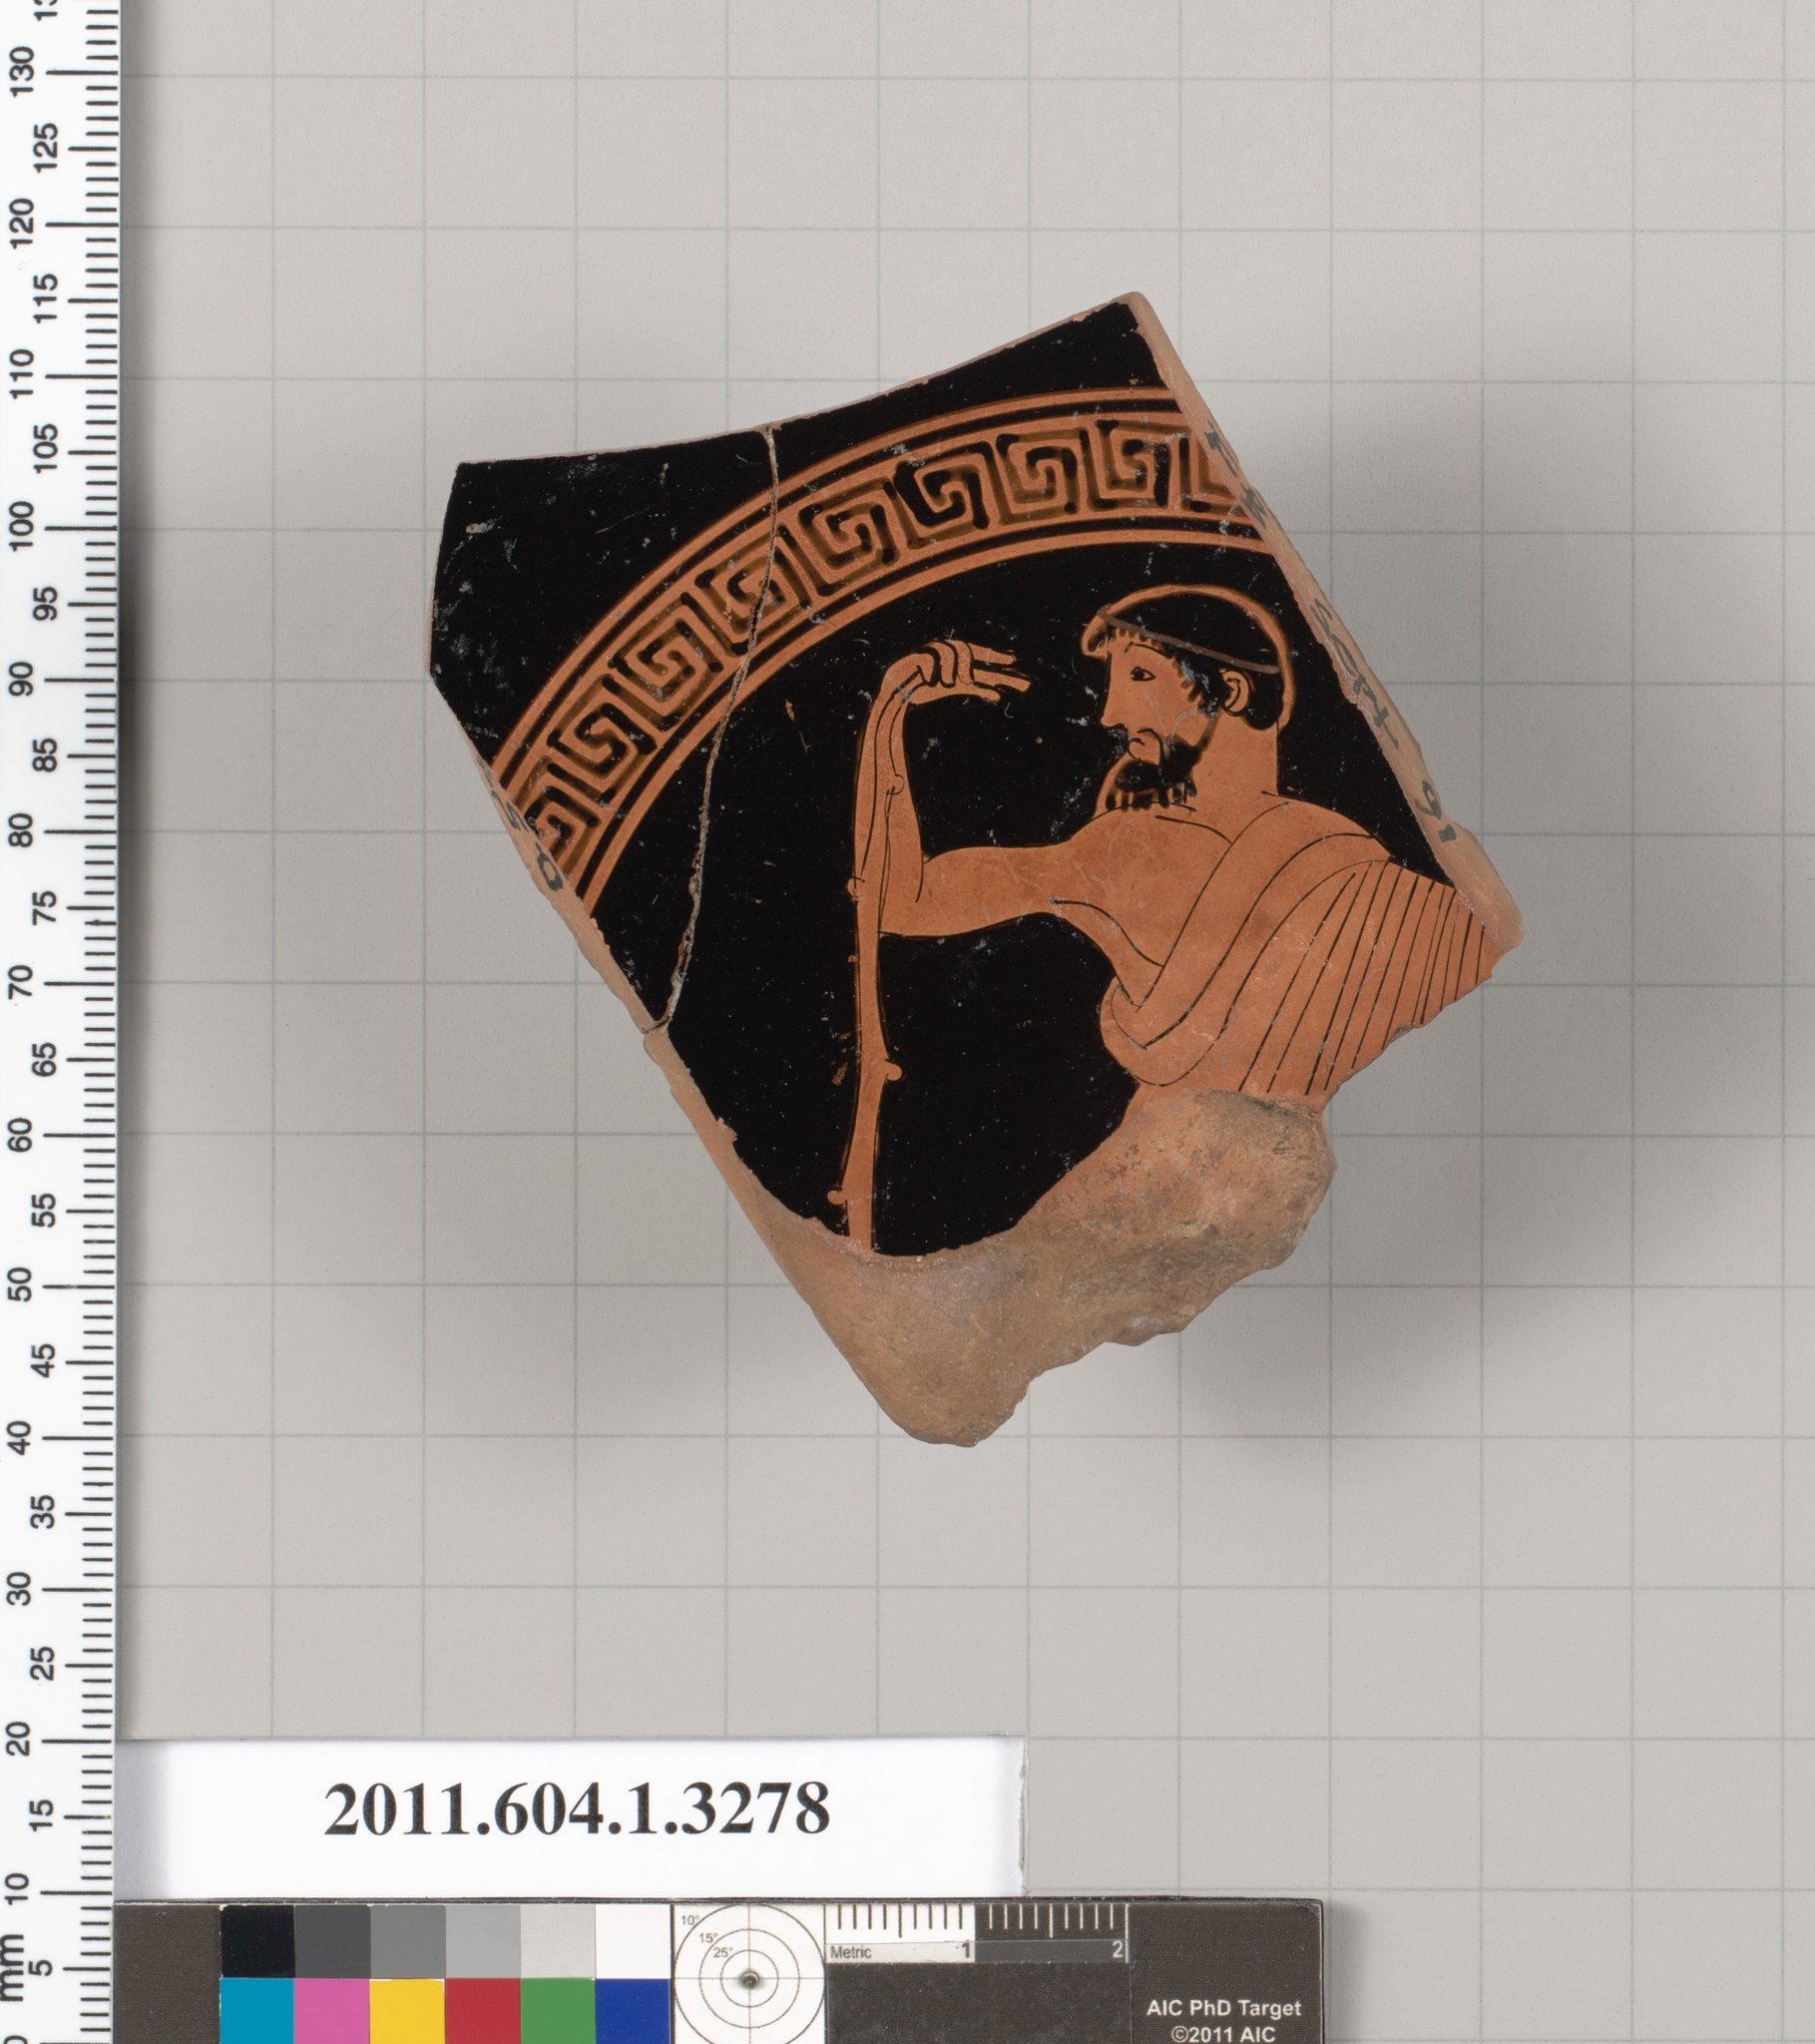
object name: kylix fragment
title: Terracotta fragment of a kylix (drinking cup)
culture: greek, attic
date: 470-460 BCE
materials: terracotta